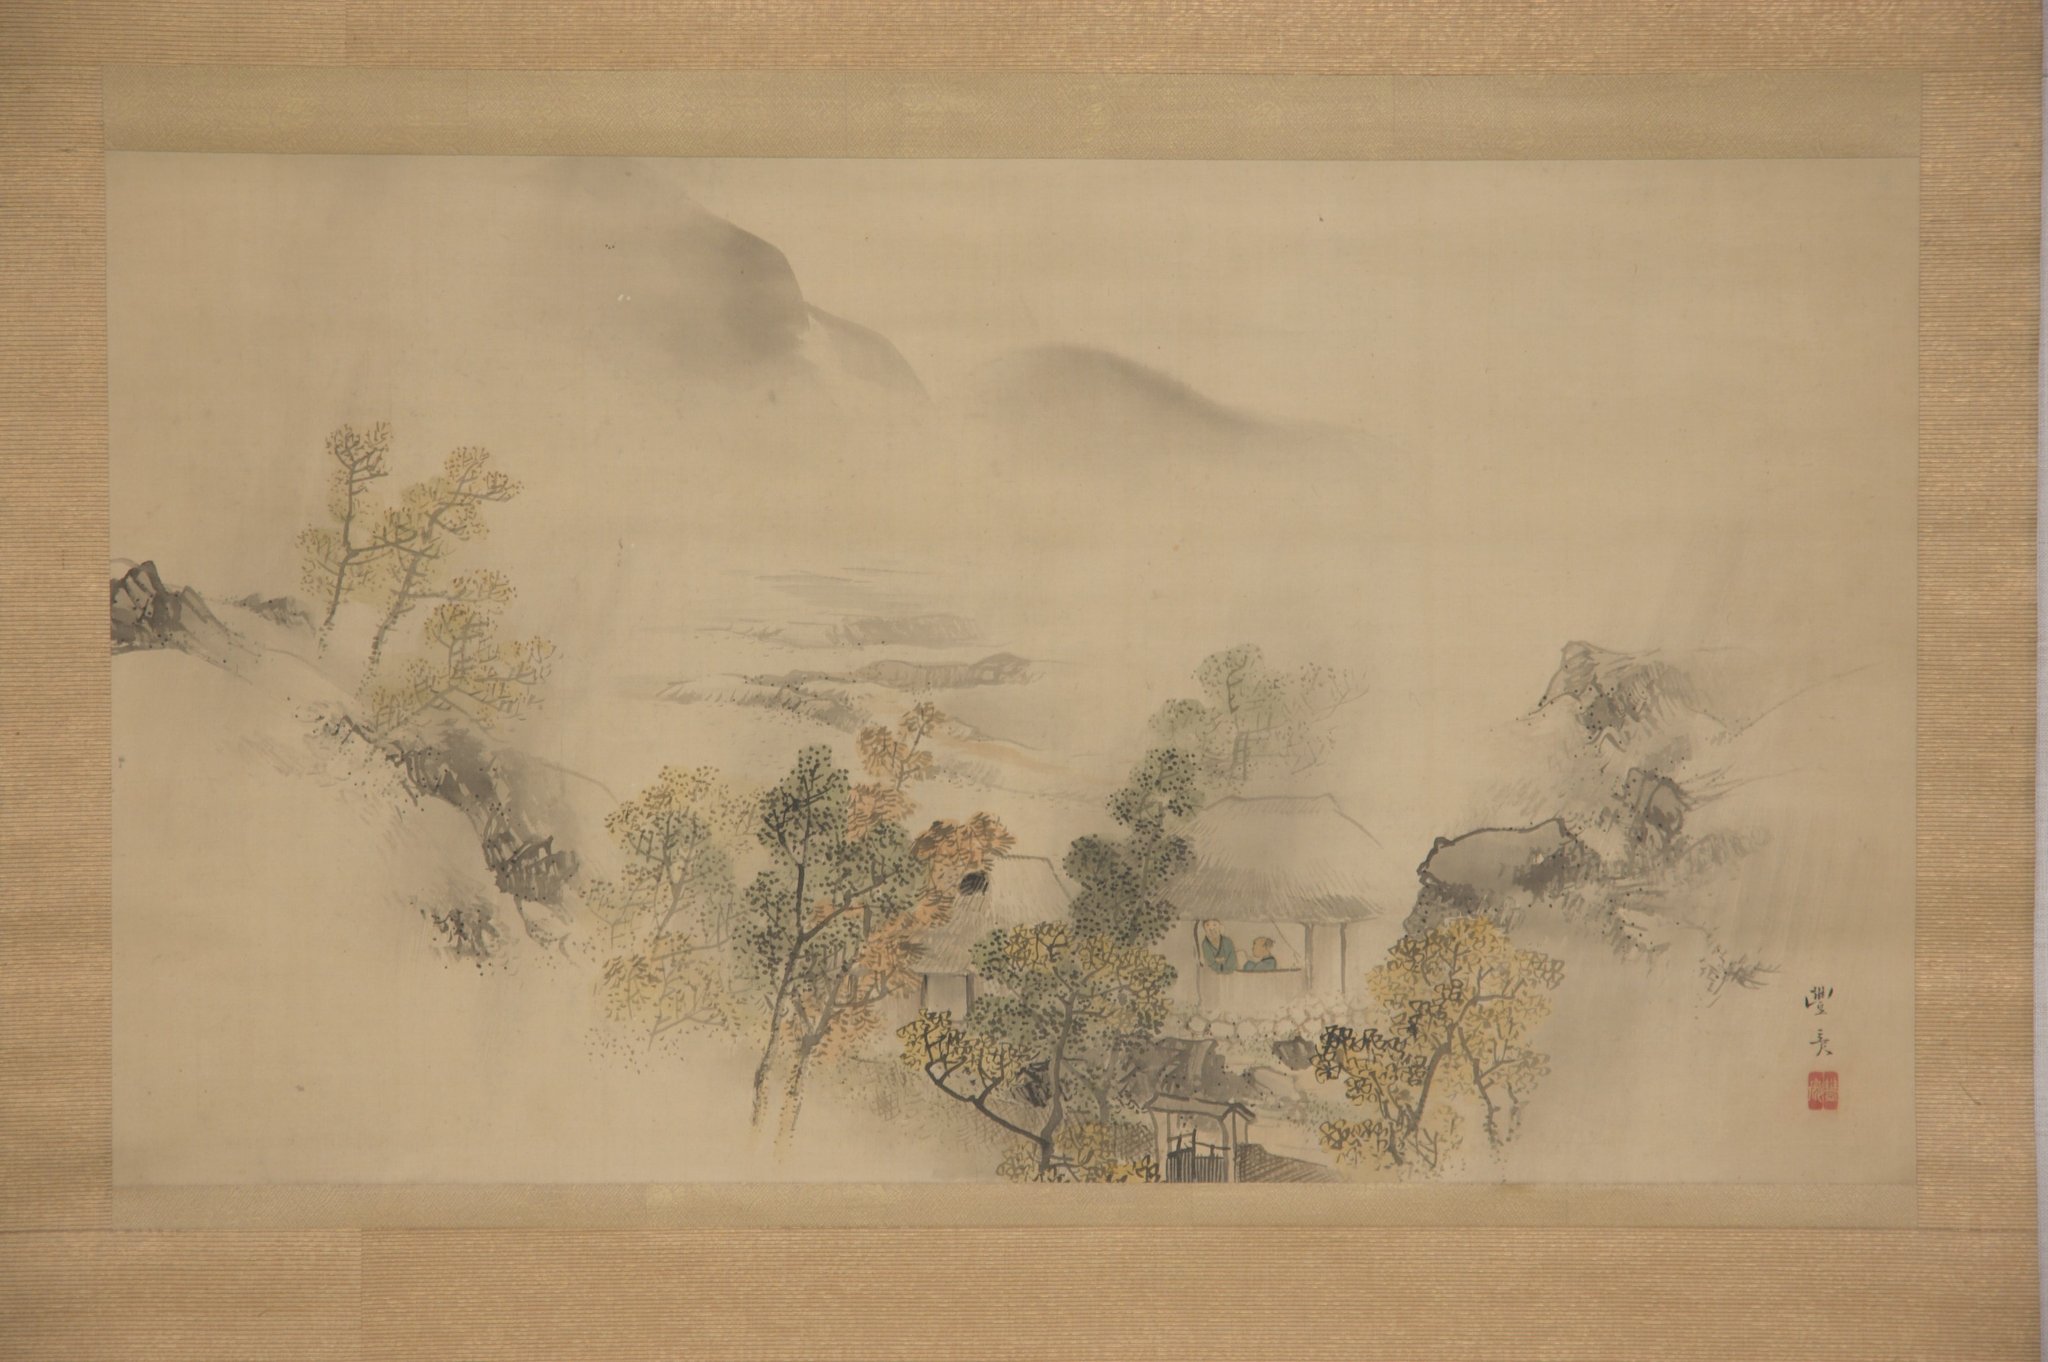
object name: hanging scroll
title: Autumn Landscape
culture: japanese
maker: okamoto toyohiko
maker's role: artist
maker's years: 1773-1845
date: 1801-1900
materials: ink, silk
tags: landscapes